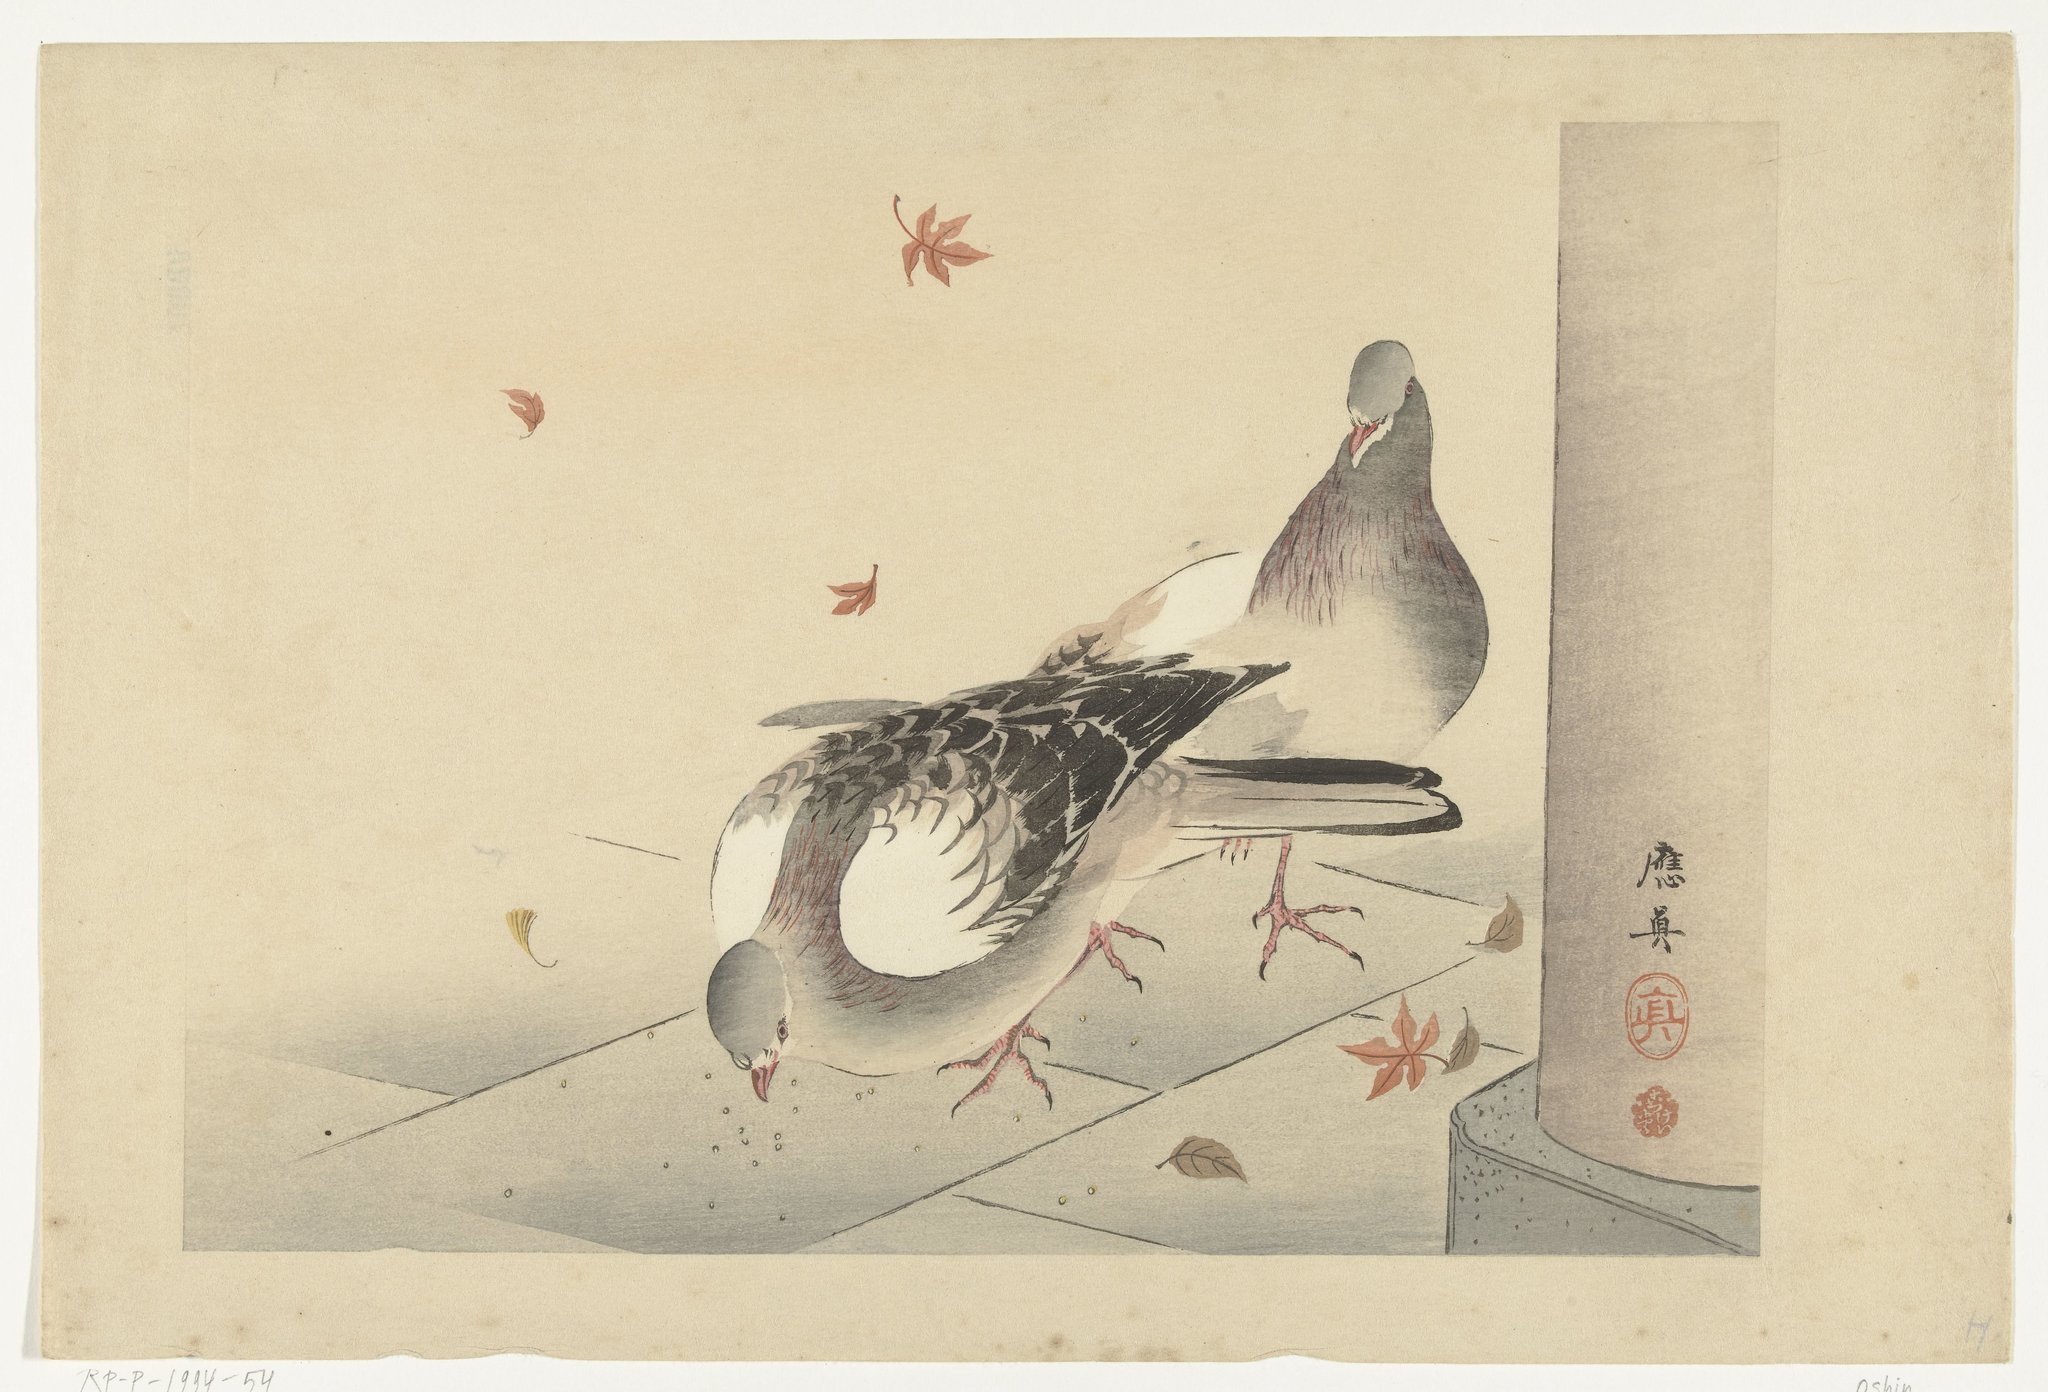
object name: print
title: Twee duiven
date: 1889-1927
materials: paper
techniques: woodcut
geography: japan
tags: doves, pigeons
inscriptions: collector's mark: Lugt 2228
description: Twee duiven op straat, tussen vallende herfstblaadjes.